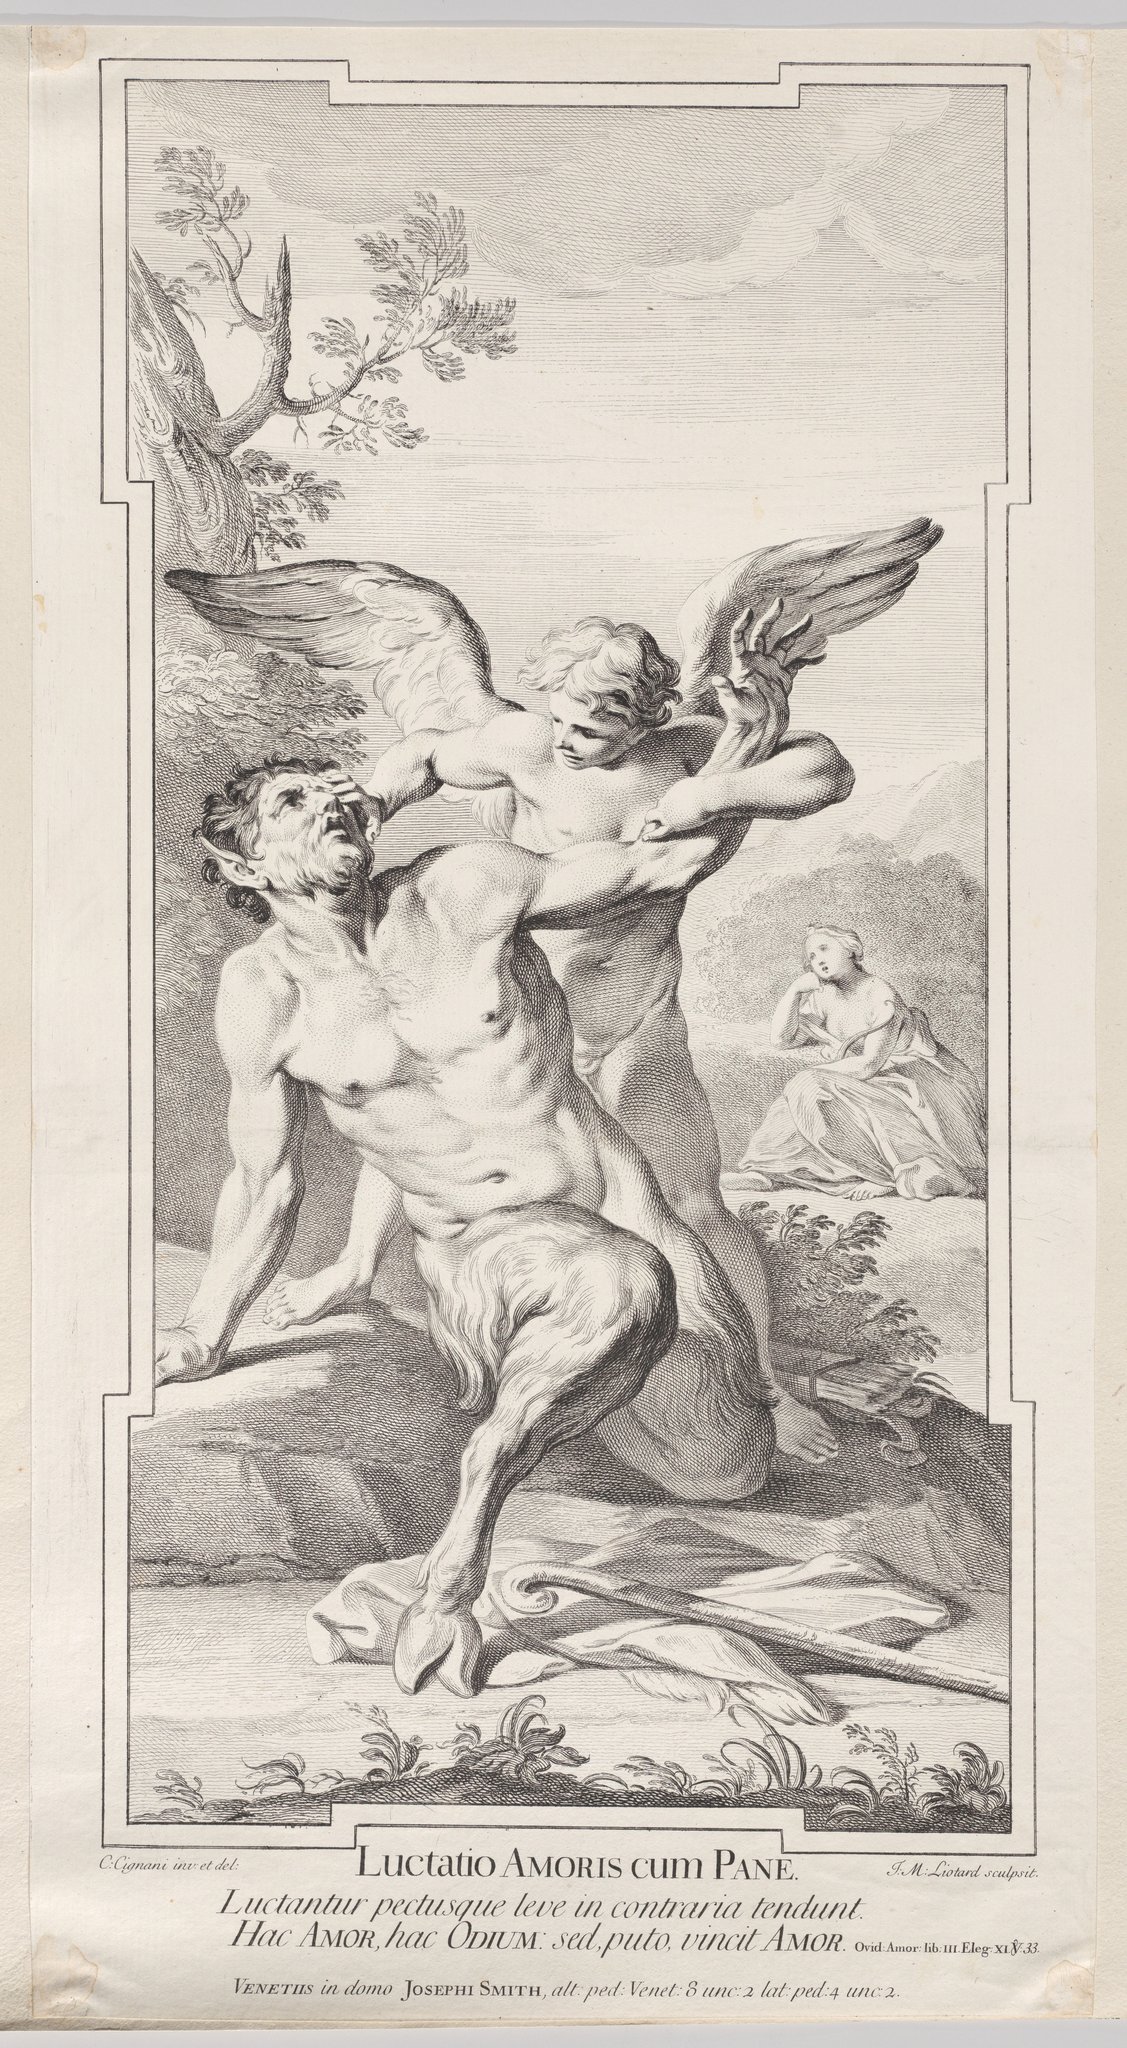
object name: print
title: Battle of Love and Pan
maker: jean michel liotard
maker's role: artist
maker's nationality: swiss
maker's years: 1702-1796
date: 1715-1796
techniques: engraving, etching